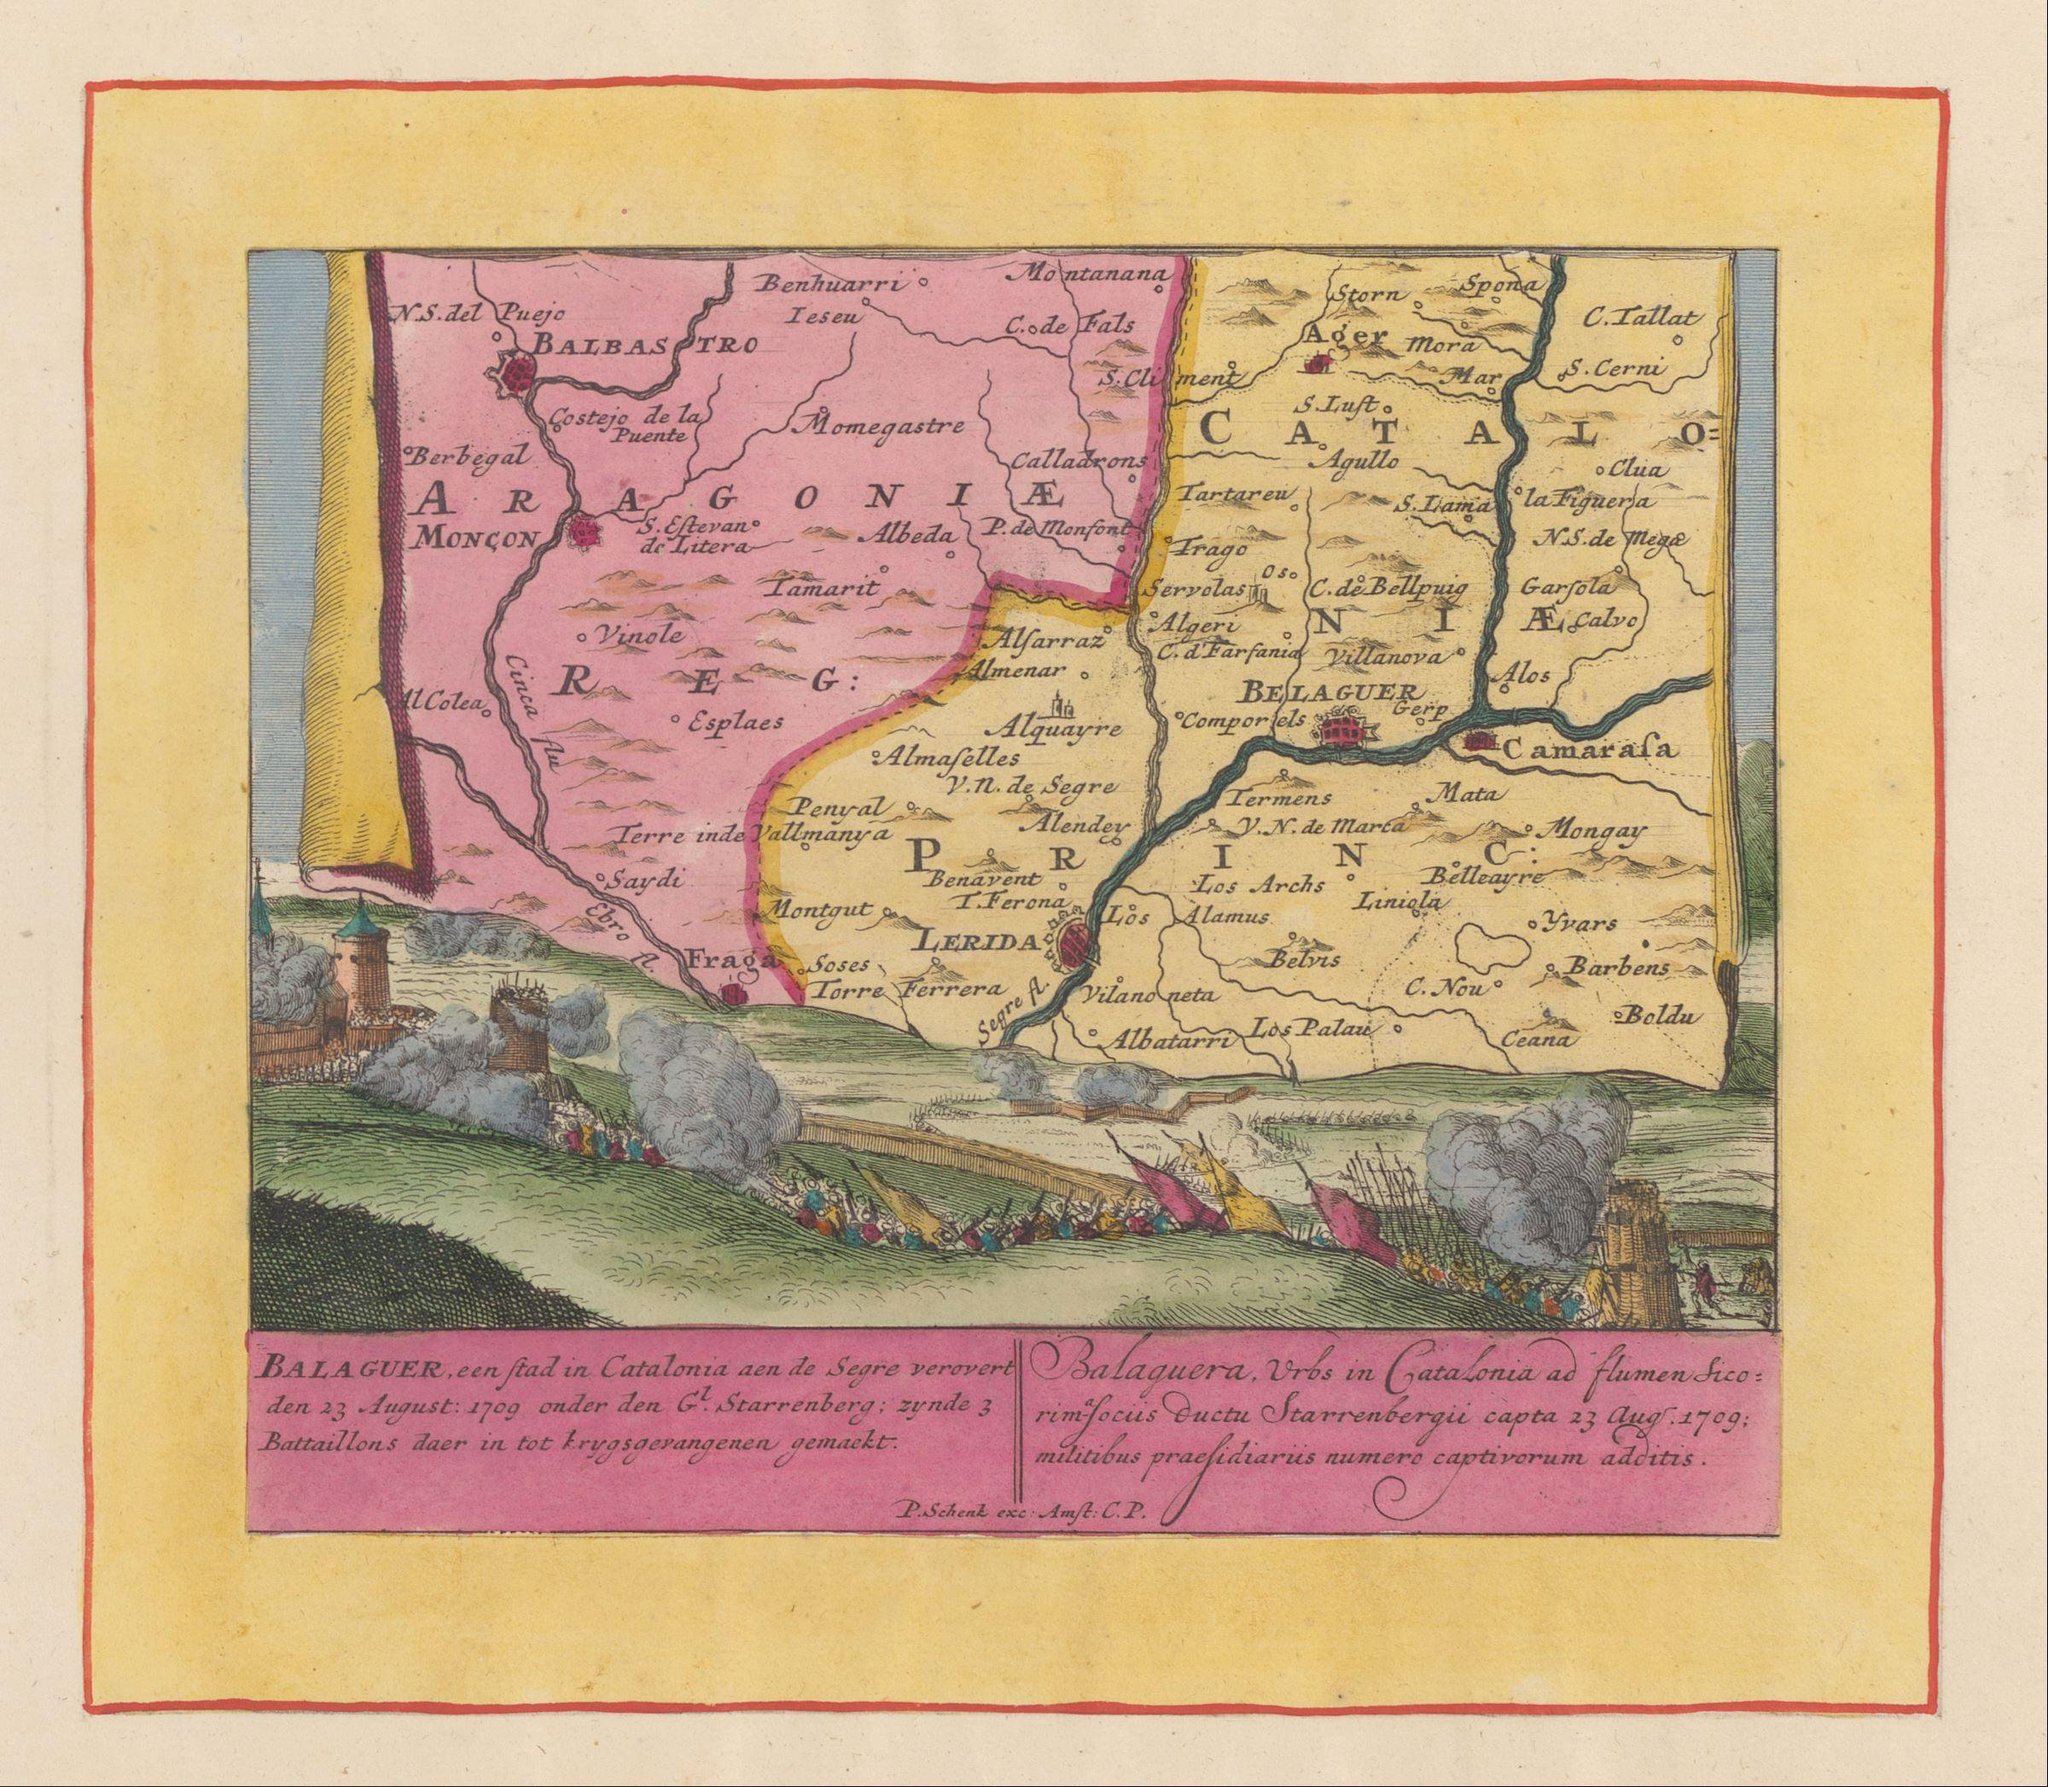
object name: album leaf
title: Schouwburg van den Oorlog, Beginnende van Koning Karel den II. Tot op Koning Karel den III. Bestaande in IX. Historische Figuren op een Olifants Blad, als Veldslagen, Belegeringen te Water en te Lande, met de voornaamste Vestingen (...)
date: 1707-1720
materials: paper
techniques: etching, hand coloring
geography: amsterdam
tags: capture of city (after the siege)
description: Prent uit: Schouwburg van den oorlog, beginnende van Karel den II. tot op koning Karel den III. : bestaande in IX historische figuren op een olifants blad, als veldslagen, belegeringen te water en te lande, met de voornaamste vestingen. Amsterdam: Pieter Schenk, 1709.